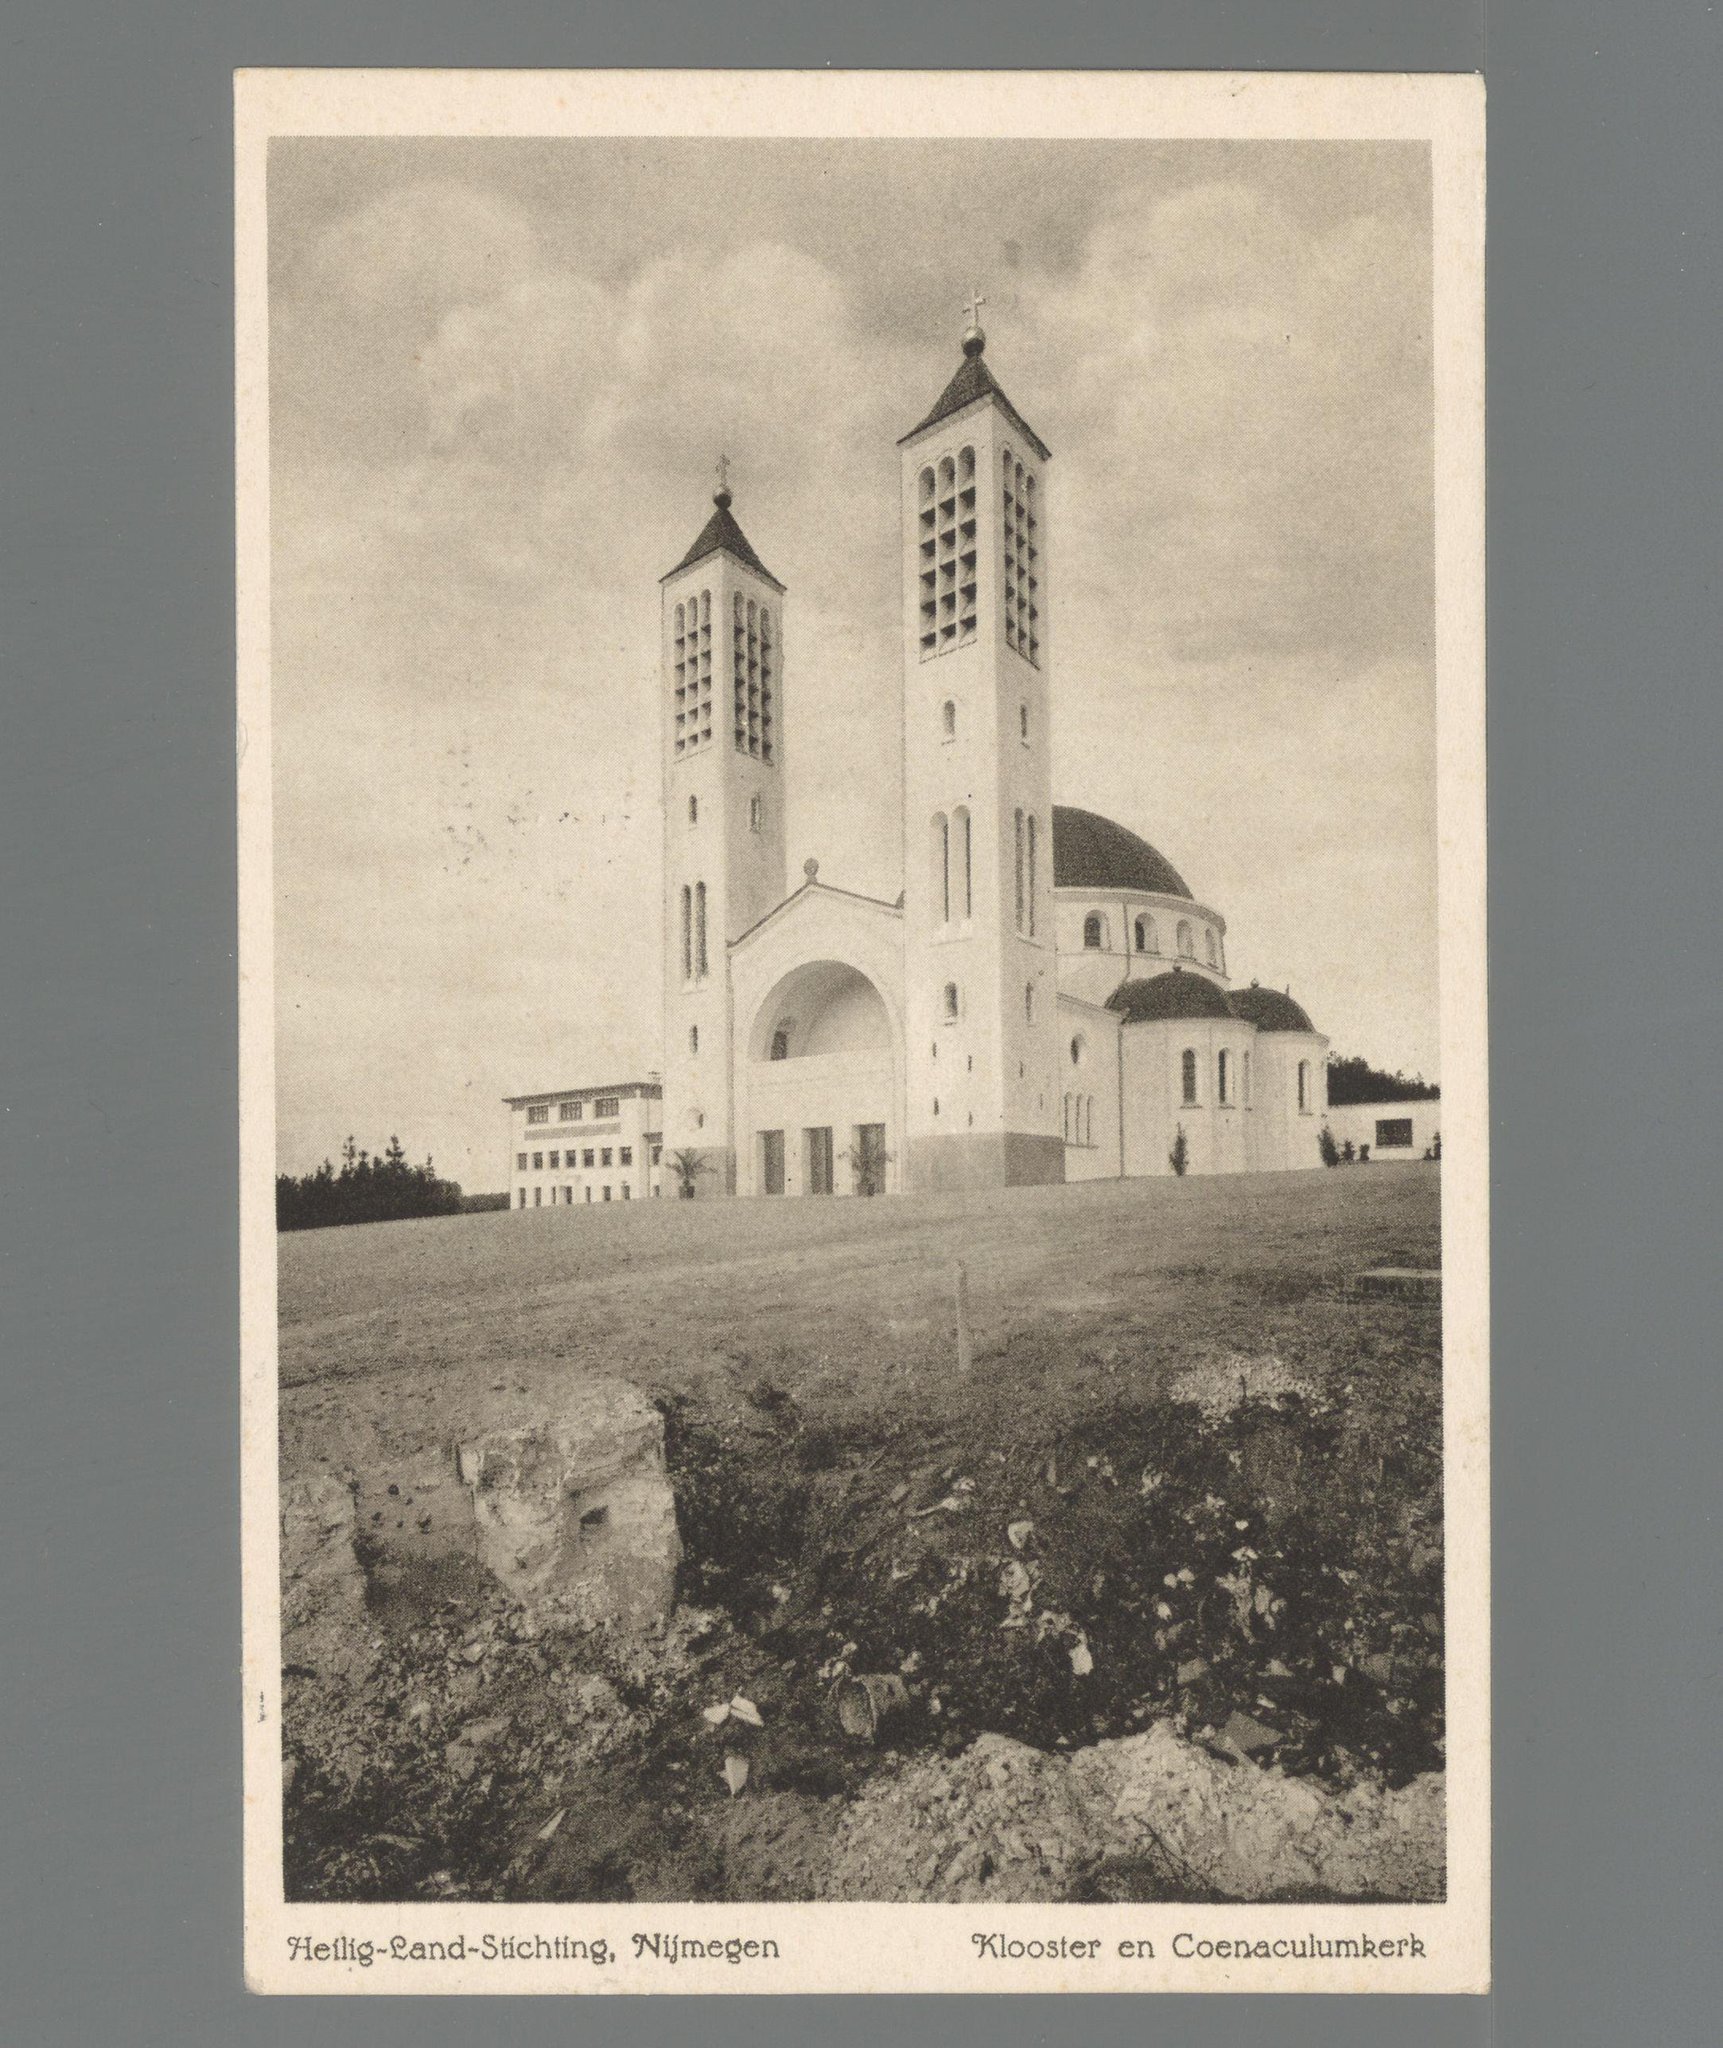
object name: photomechanical print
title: Heilig-Land-Stichting, Nijmegen. Klooster en Coenaculumkerk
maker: Anonymous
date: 1913-1917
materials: cardboard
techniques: rotogravure, writing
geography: heilig landstichting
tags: church (exterior)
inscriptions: postage stamp